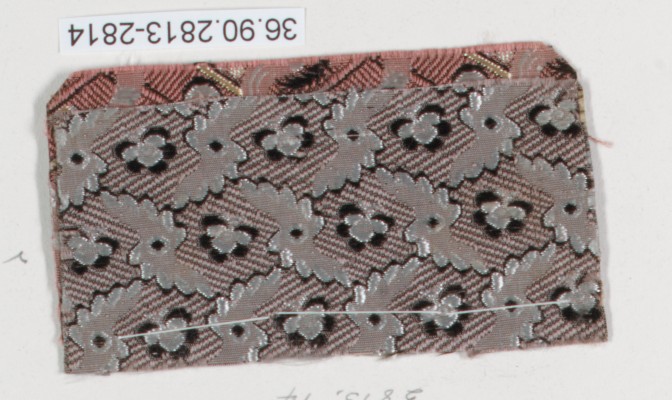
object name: piece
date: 1801-1900